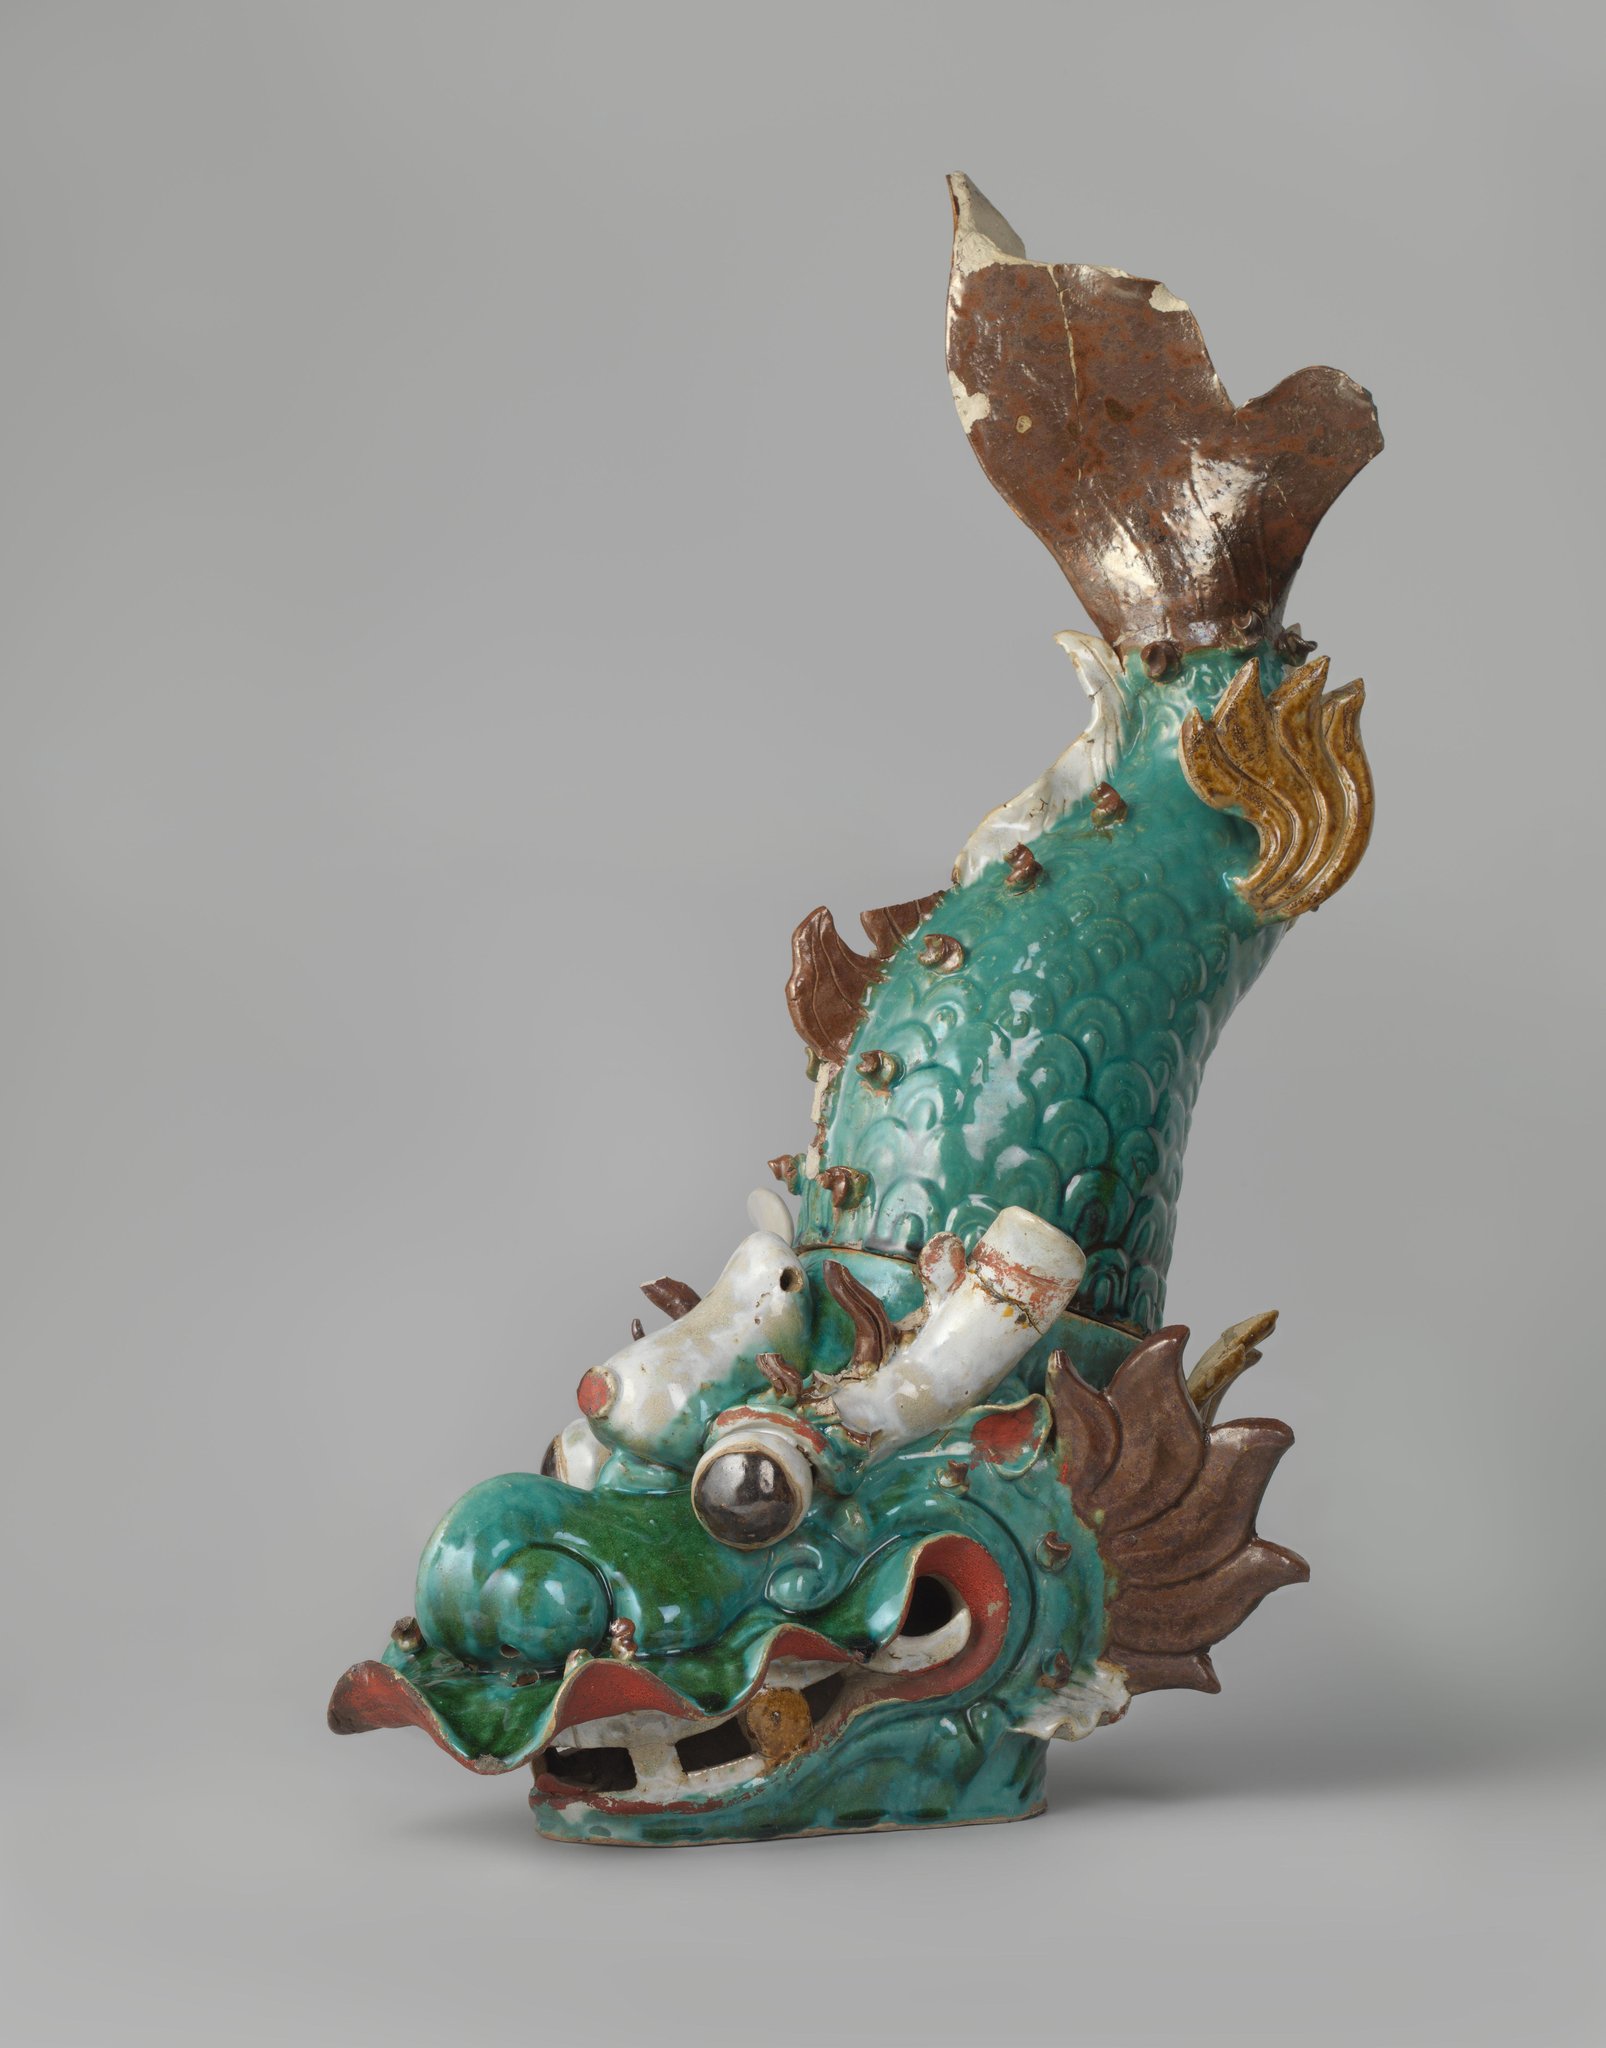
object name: architectural element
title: Draak/zeemonster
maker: Anonymous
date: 1850-1875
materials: dye, earthenware, glaze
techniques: vitrification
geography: china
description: Kop gedeelte van de draak/zeemonster, bestaande uit twee delen, verbonden met een houten staaf. De draak staat op zijn onderkaak, de staart steekt omhoog. Blauw, bruin, rood en wit geglazuurd en beschilderd.